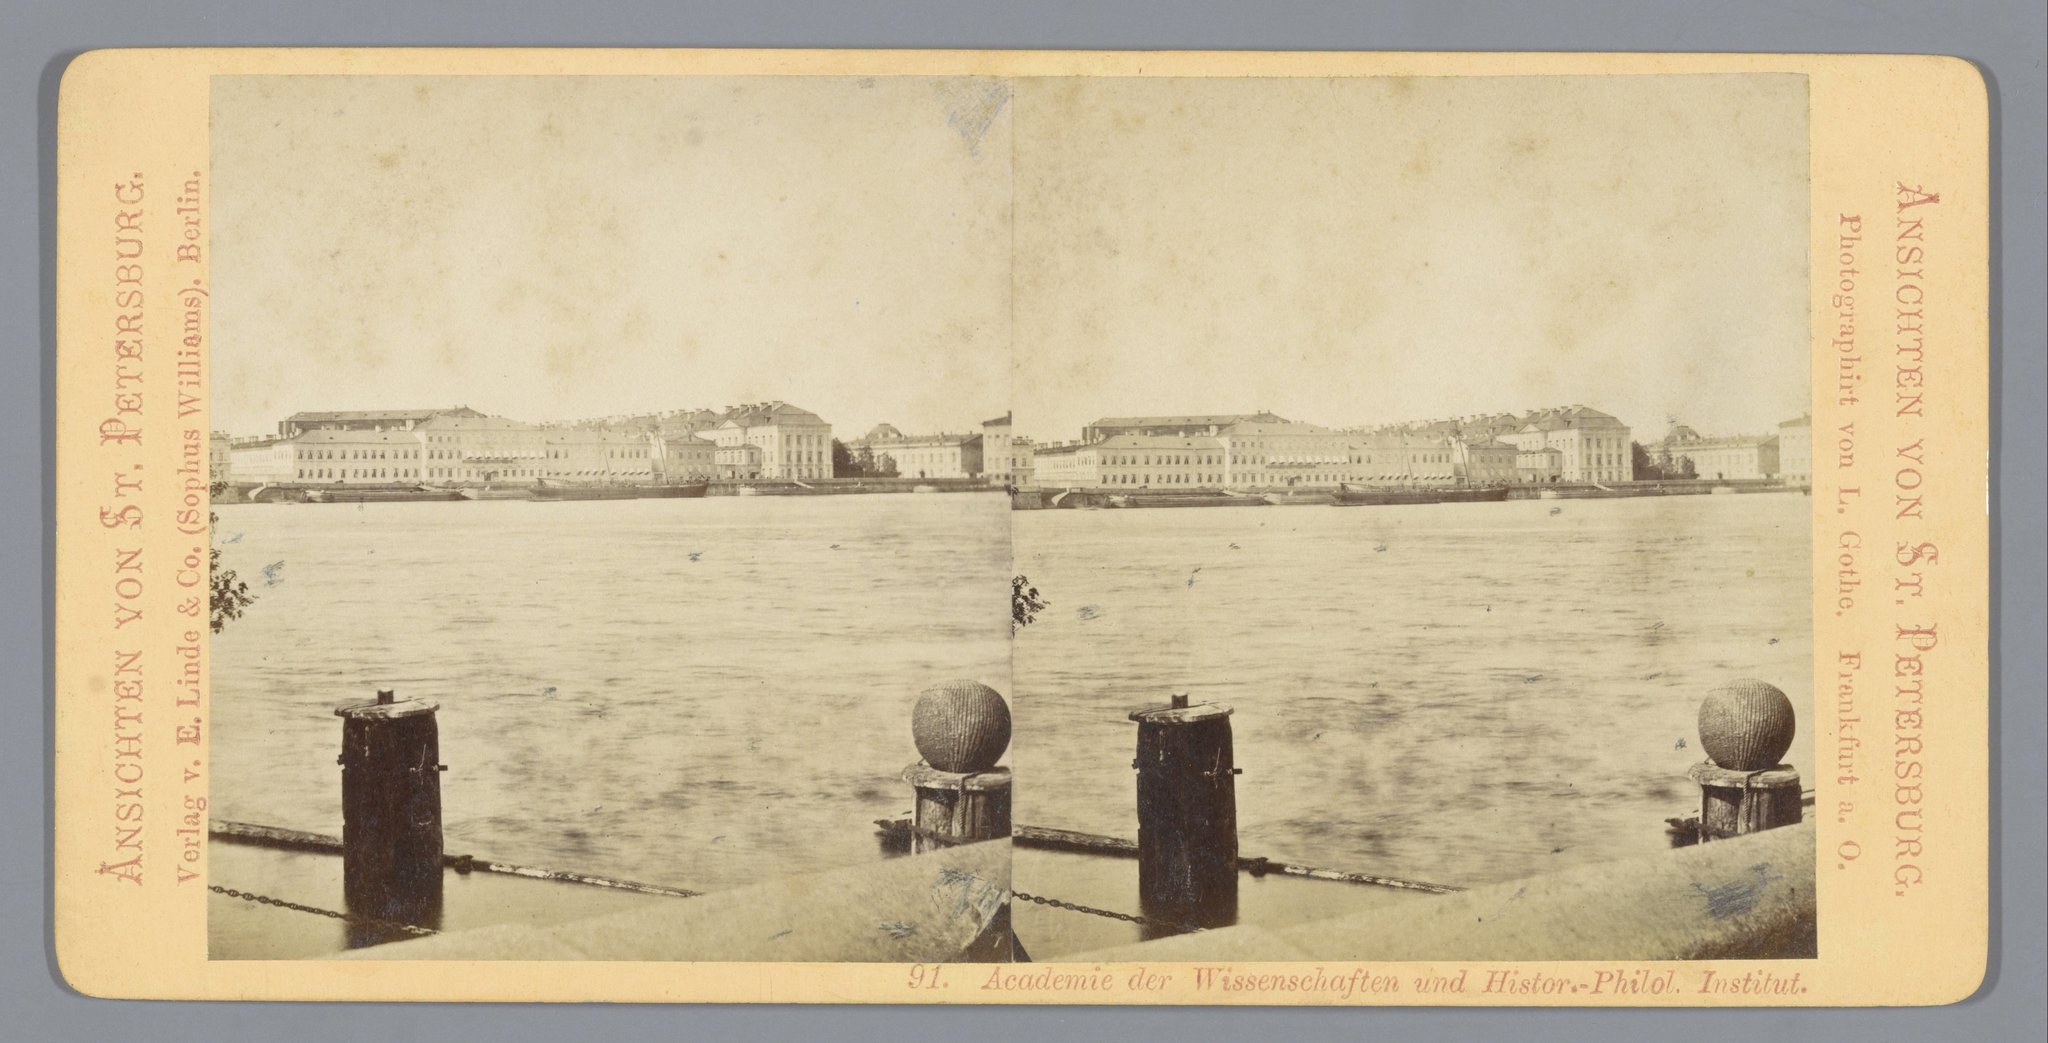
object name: stereograph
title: Gezicht op de Russische Academie van Wetenschappen in Sint-Petersburg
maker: louis gothe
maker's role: fotograaf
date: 1850-1880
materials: cardboard, photographic support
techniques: albumen print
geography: sint-petersburg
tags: learned society, academy of sciences, river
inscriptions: inscription: ‘Ansichten von St. Petersburg.’, number: ‘91.’